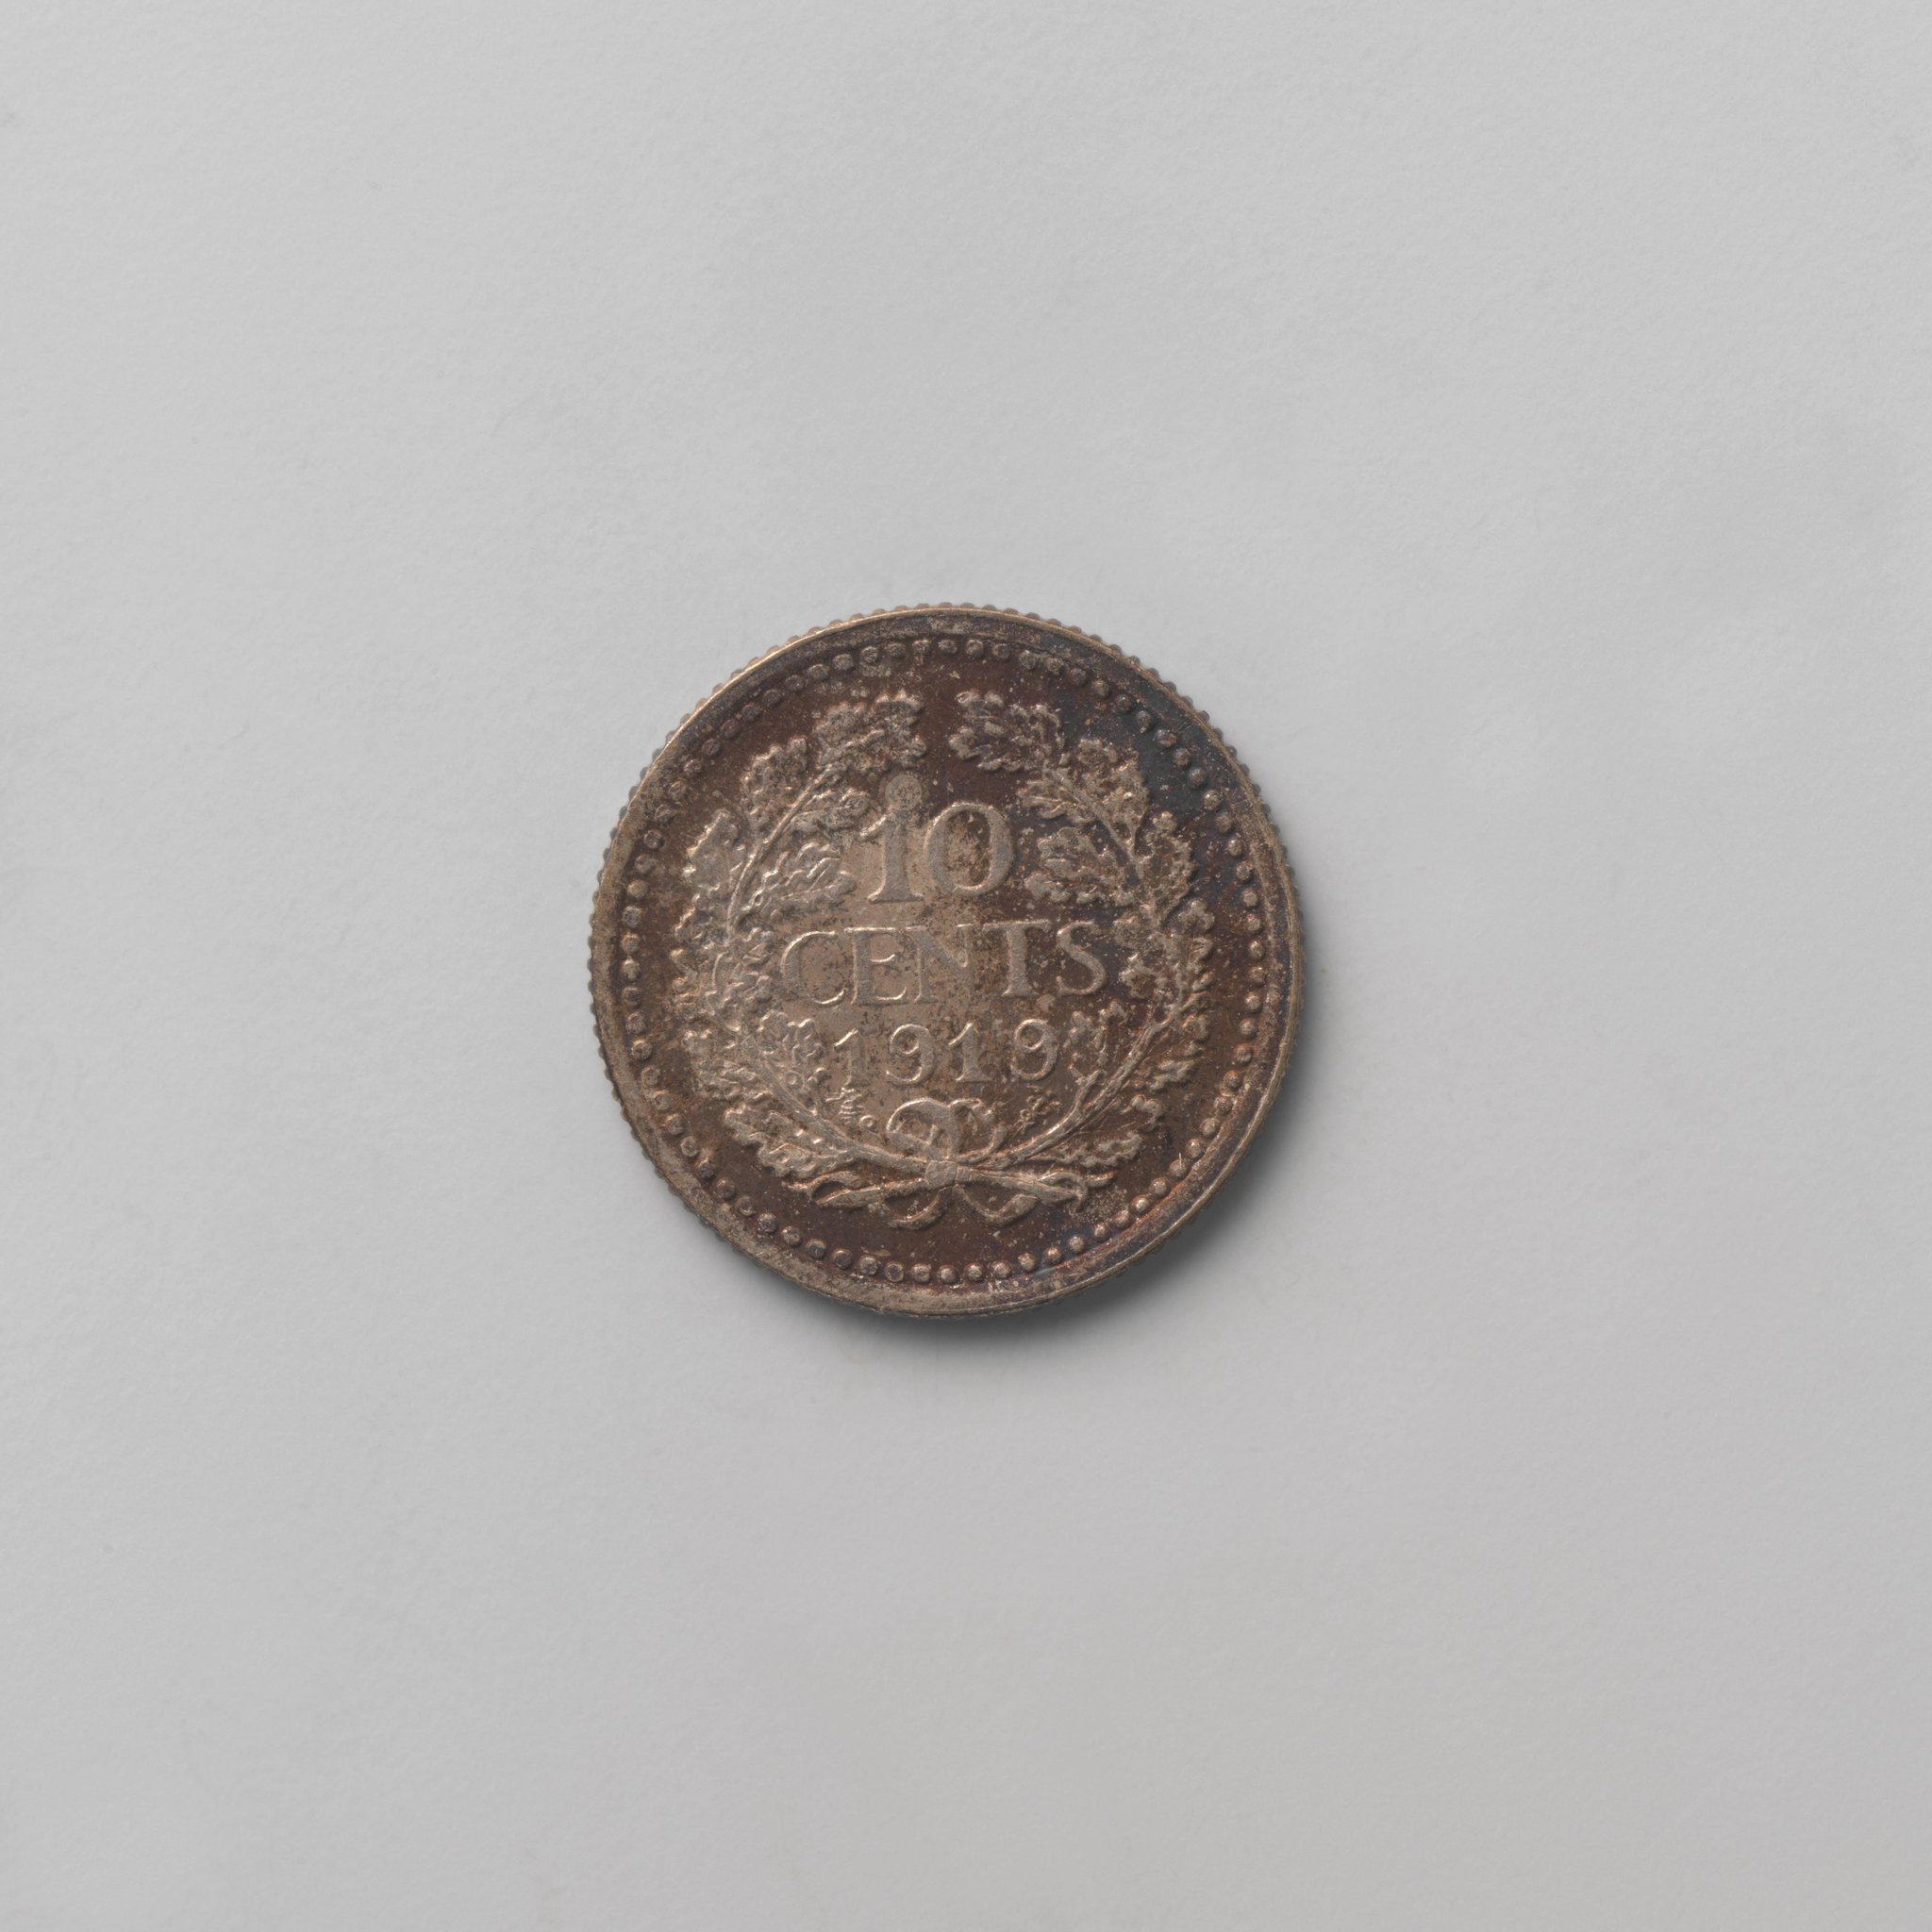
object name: coin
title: Nederlandse10 cent,1919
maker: wilhelmina of the netherlands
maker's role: print maker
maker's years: 1880-1962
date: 1919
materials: silver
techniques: striking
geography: utrecht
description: Zilveren munt. Voorzijde: gedrapeerd borstbeeld naar links. Keerzijde: binnen twee samengebonden eiketakken waarde-aanduiding 10 cents en jaartal. Kartelrand.